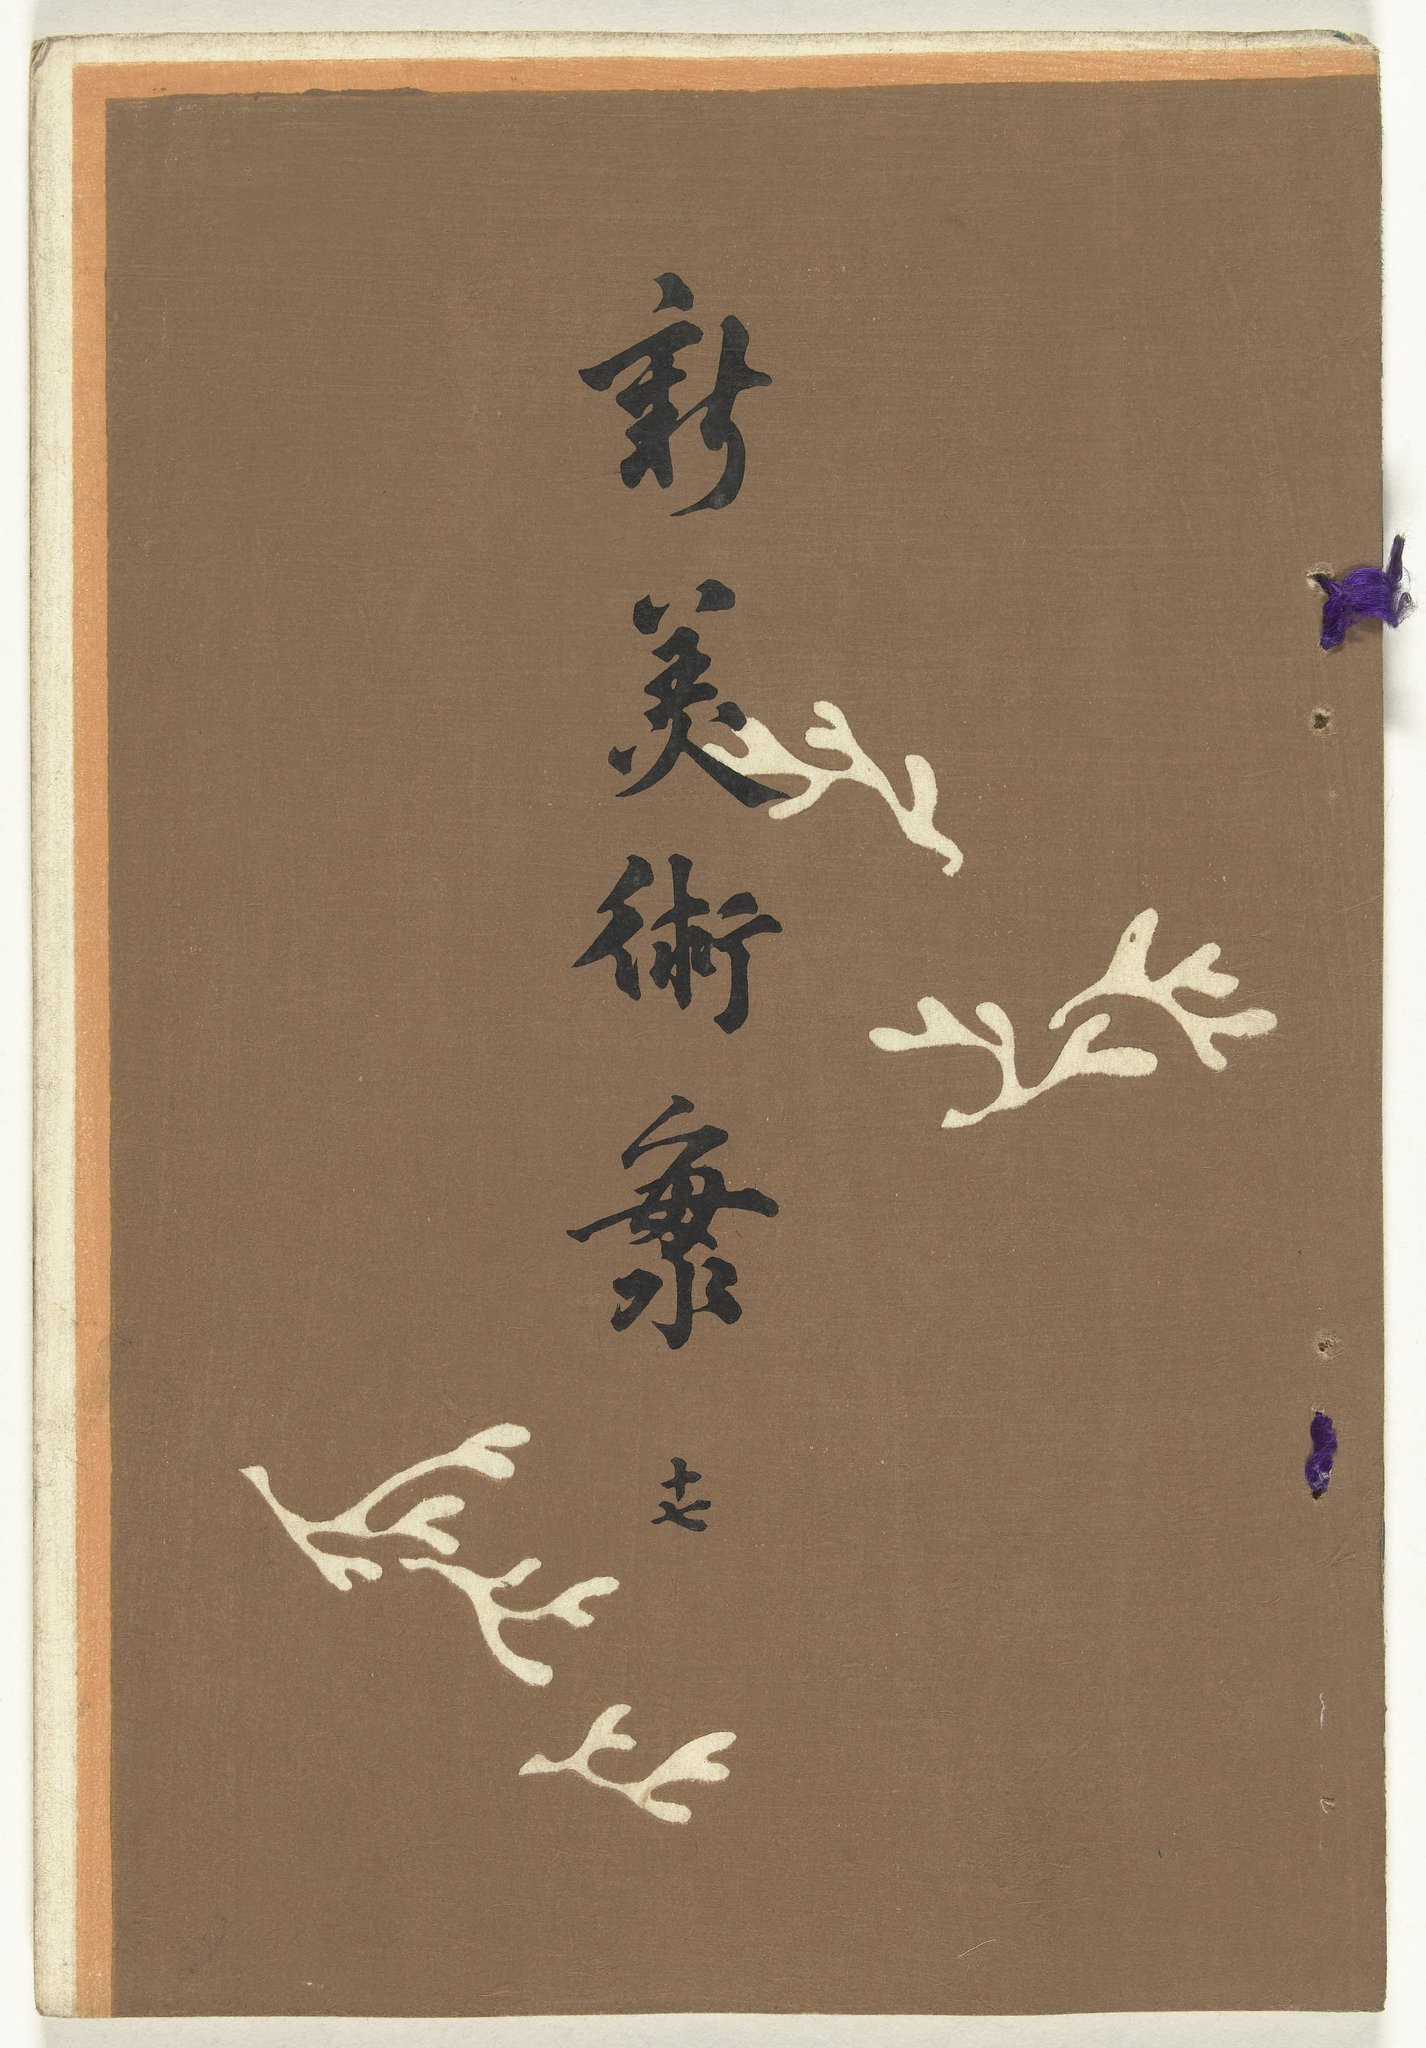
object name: book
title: Shin bijutsukai - junana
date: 1903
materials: gold powder, paper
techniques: woodcut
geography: kyoto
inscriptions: date